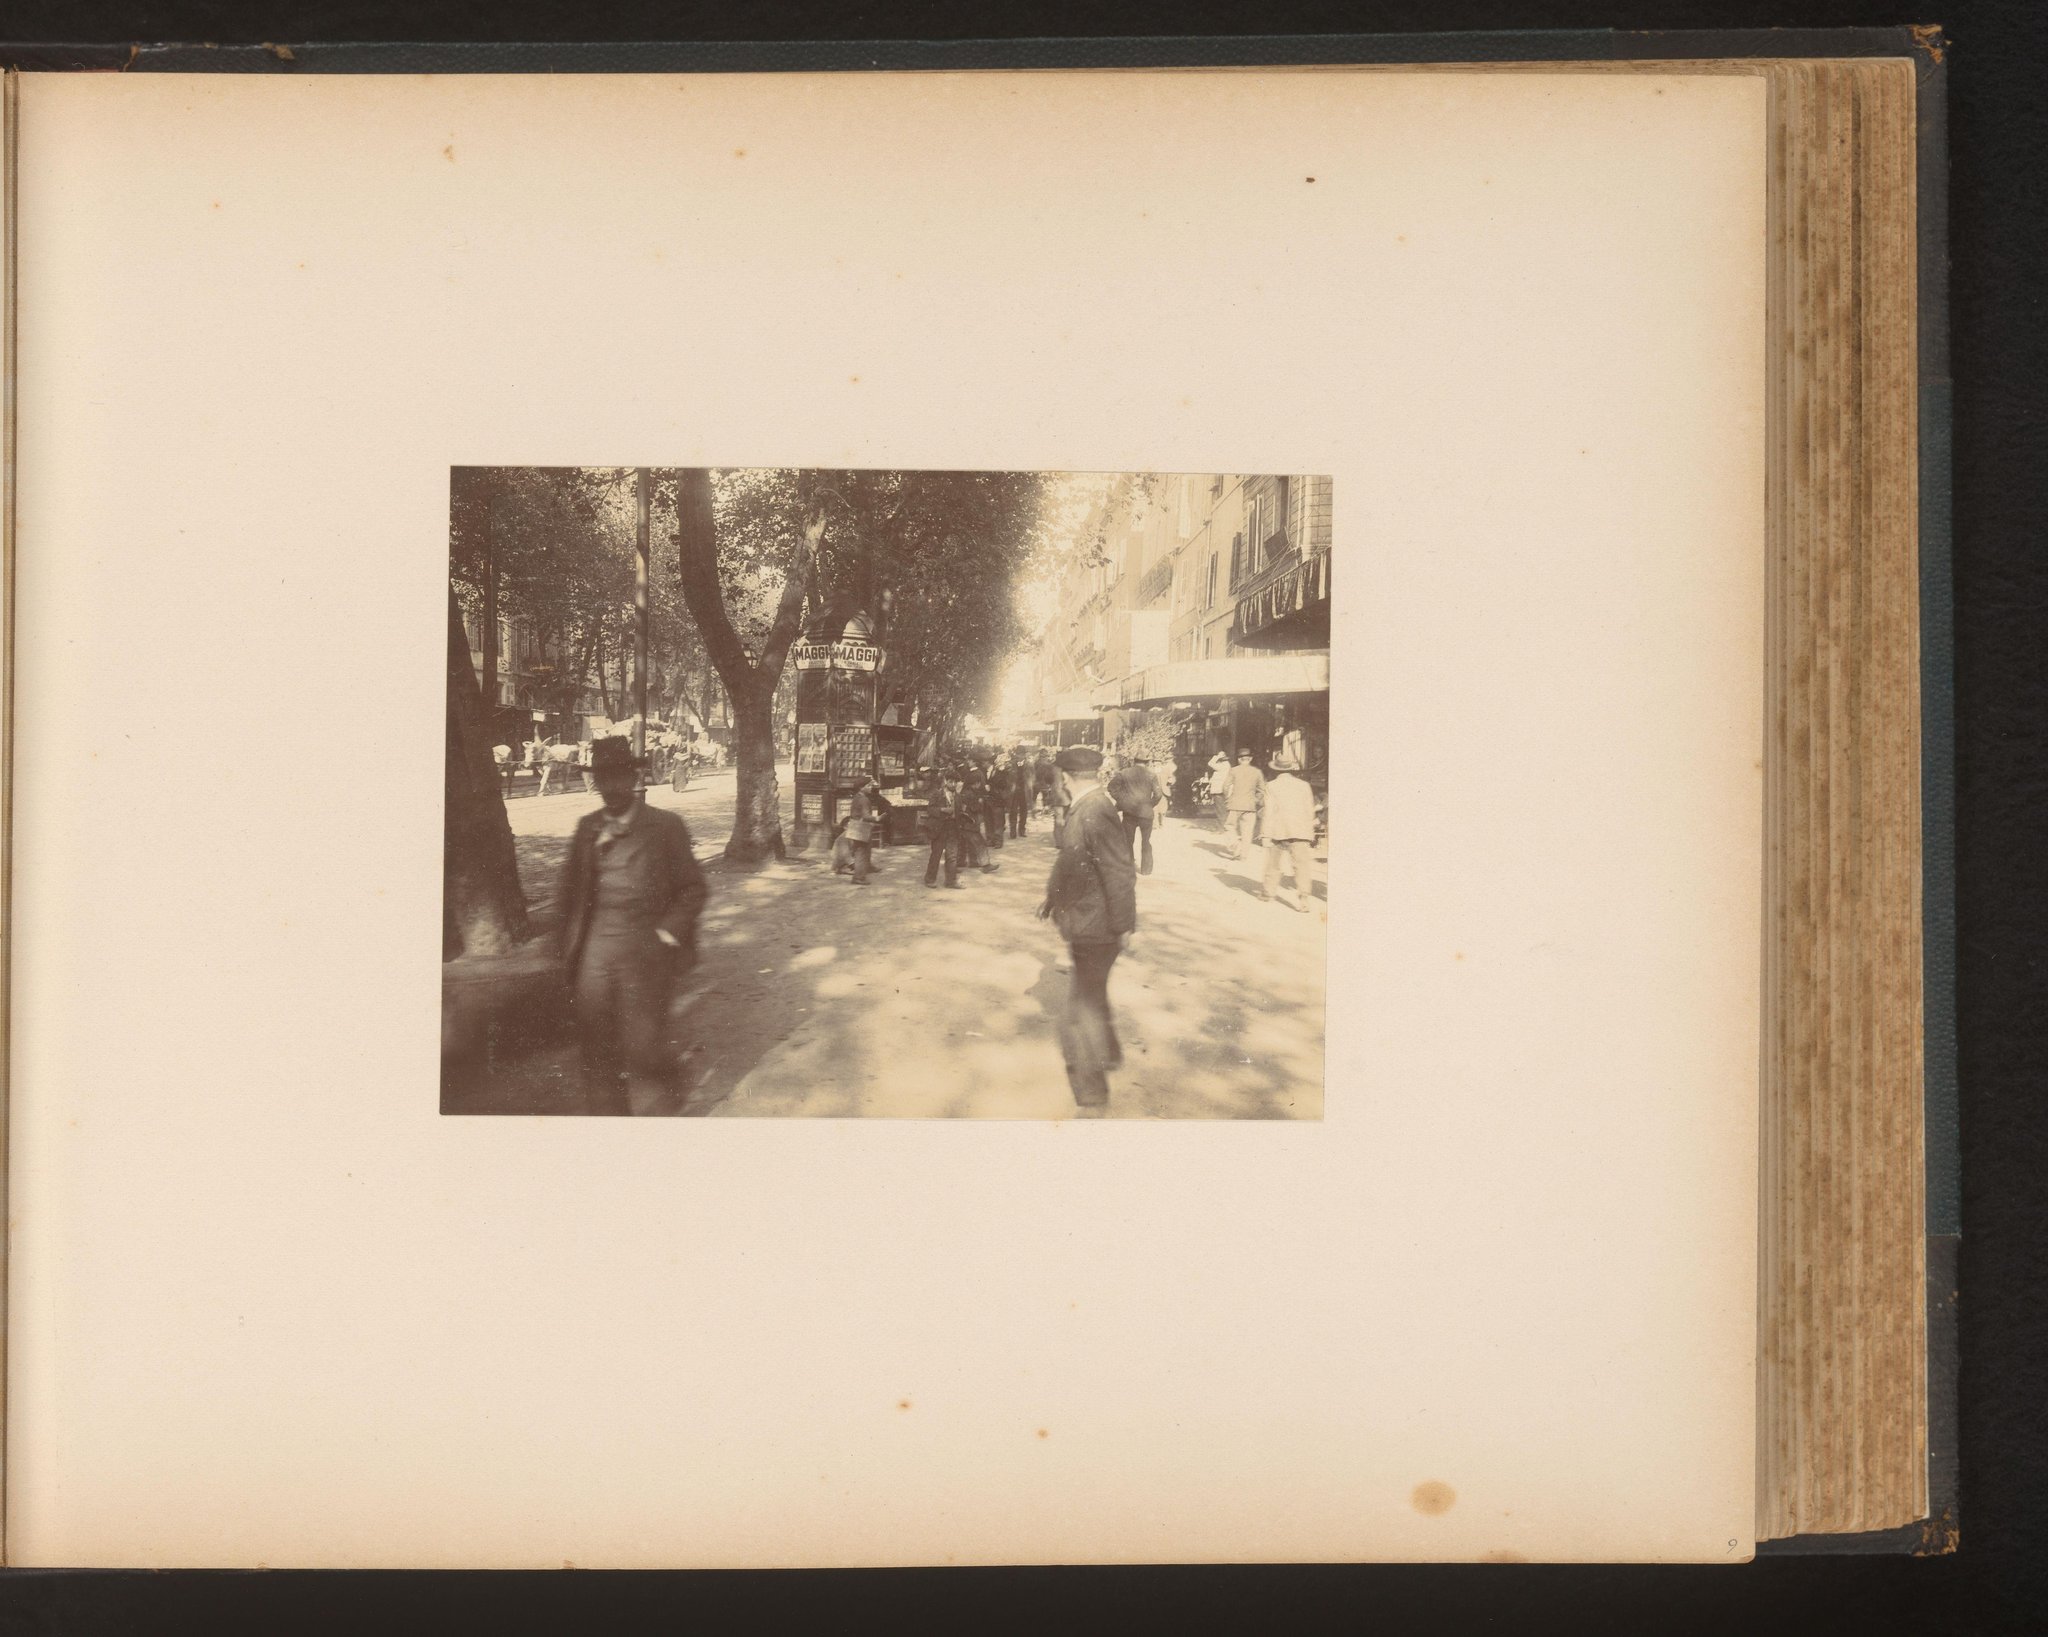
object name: photograph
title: Straatgezicht te Frankrijk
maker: Anonymous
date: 1880-1920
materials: cardboard, photographic support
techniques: gelatin silver print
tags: trees, sale of newspaper, newspaper stand, historical persons, street, france